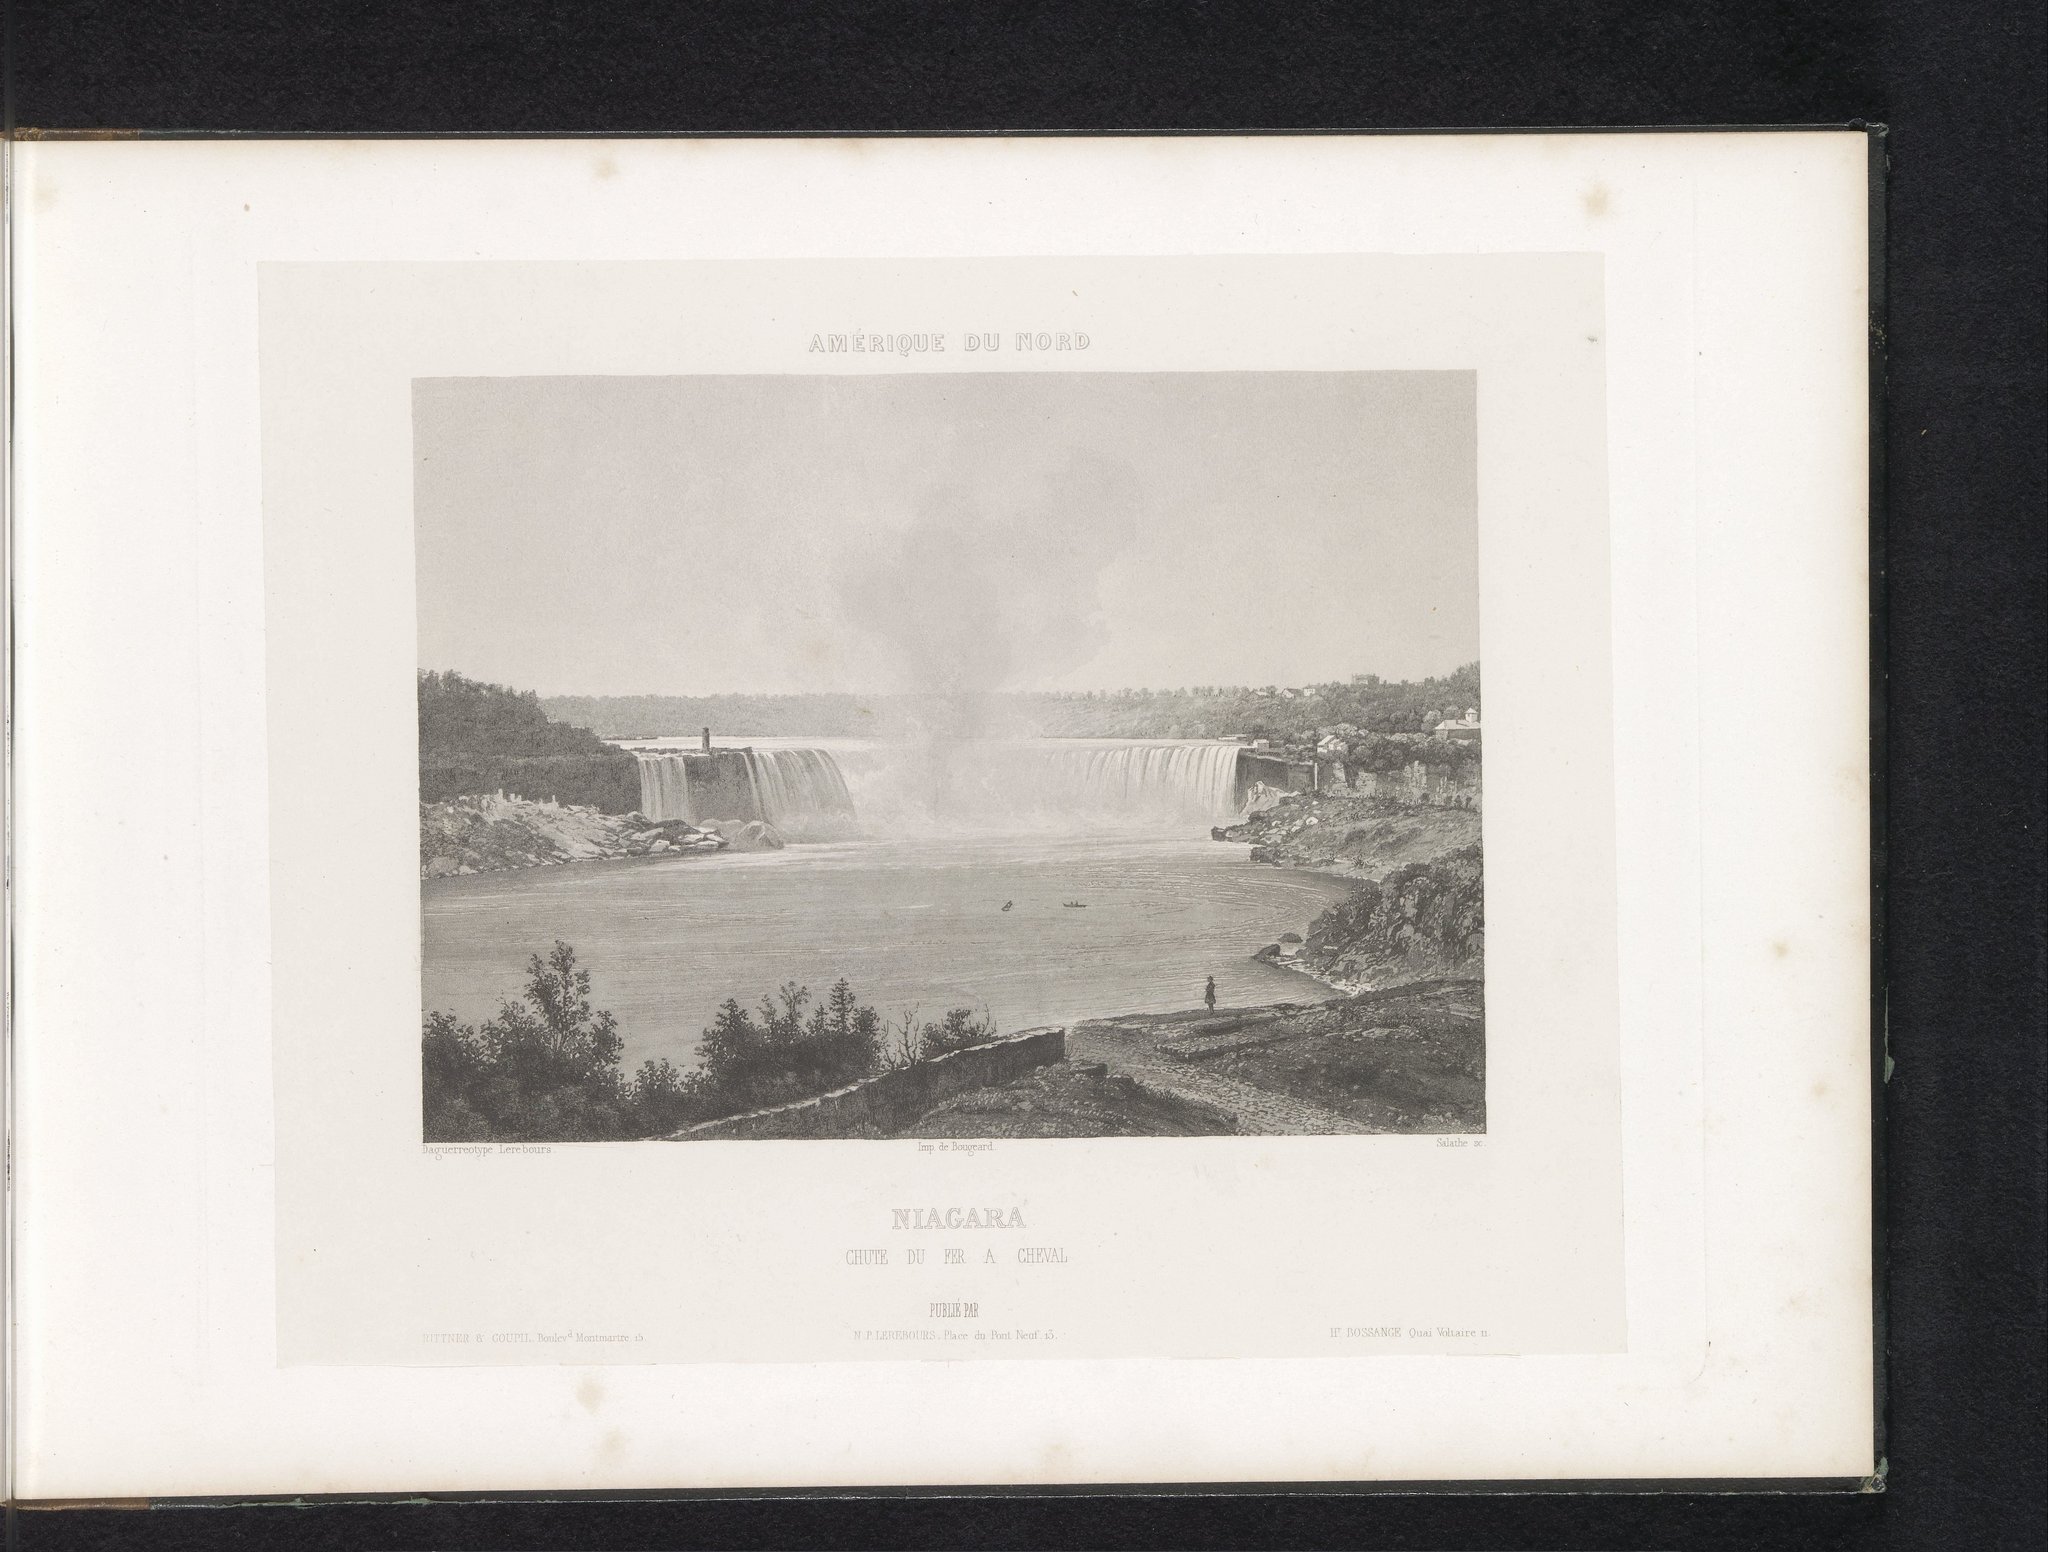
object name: page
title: Amérique du Nord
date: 1839-1841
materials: paper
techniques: aquatint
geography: paris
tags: waterfall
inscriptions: inscription: ‘Hr. Bossance Quai Voltaire 11’, inscription: ‘Rittner & Goupil Boulevd Montmartre 15’, inscription: ‘N.P. Lerebours Place du Pont Neuf 15’